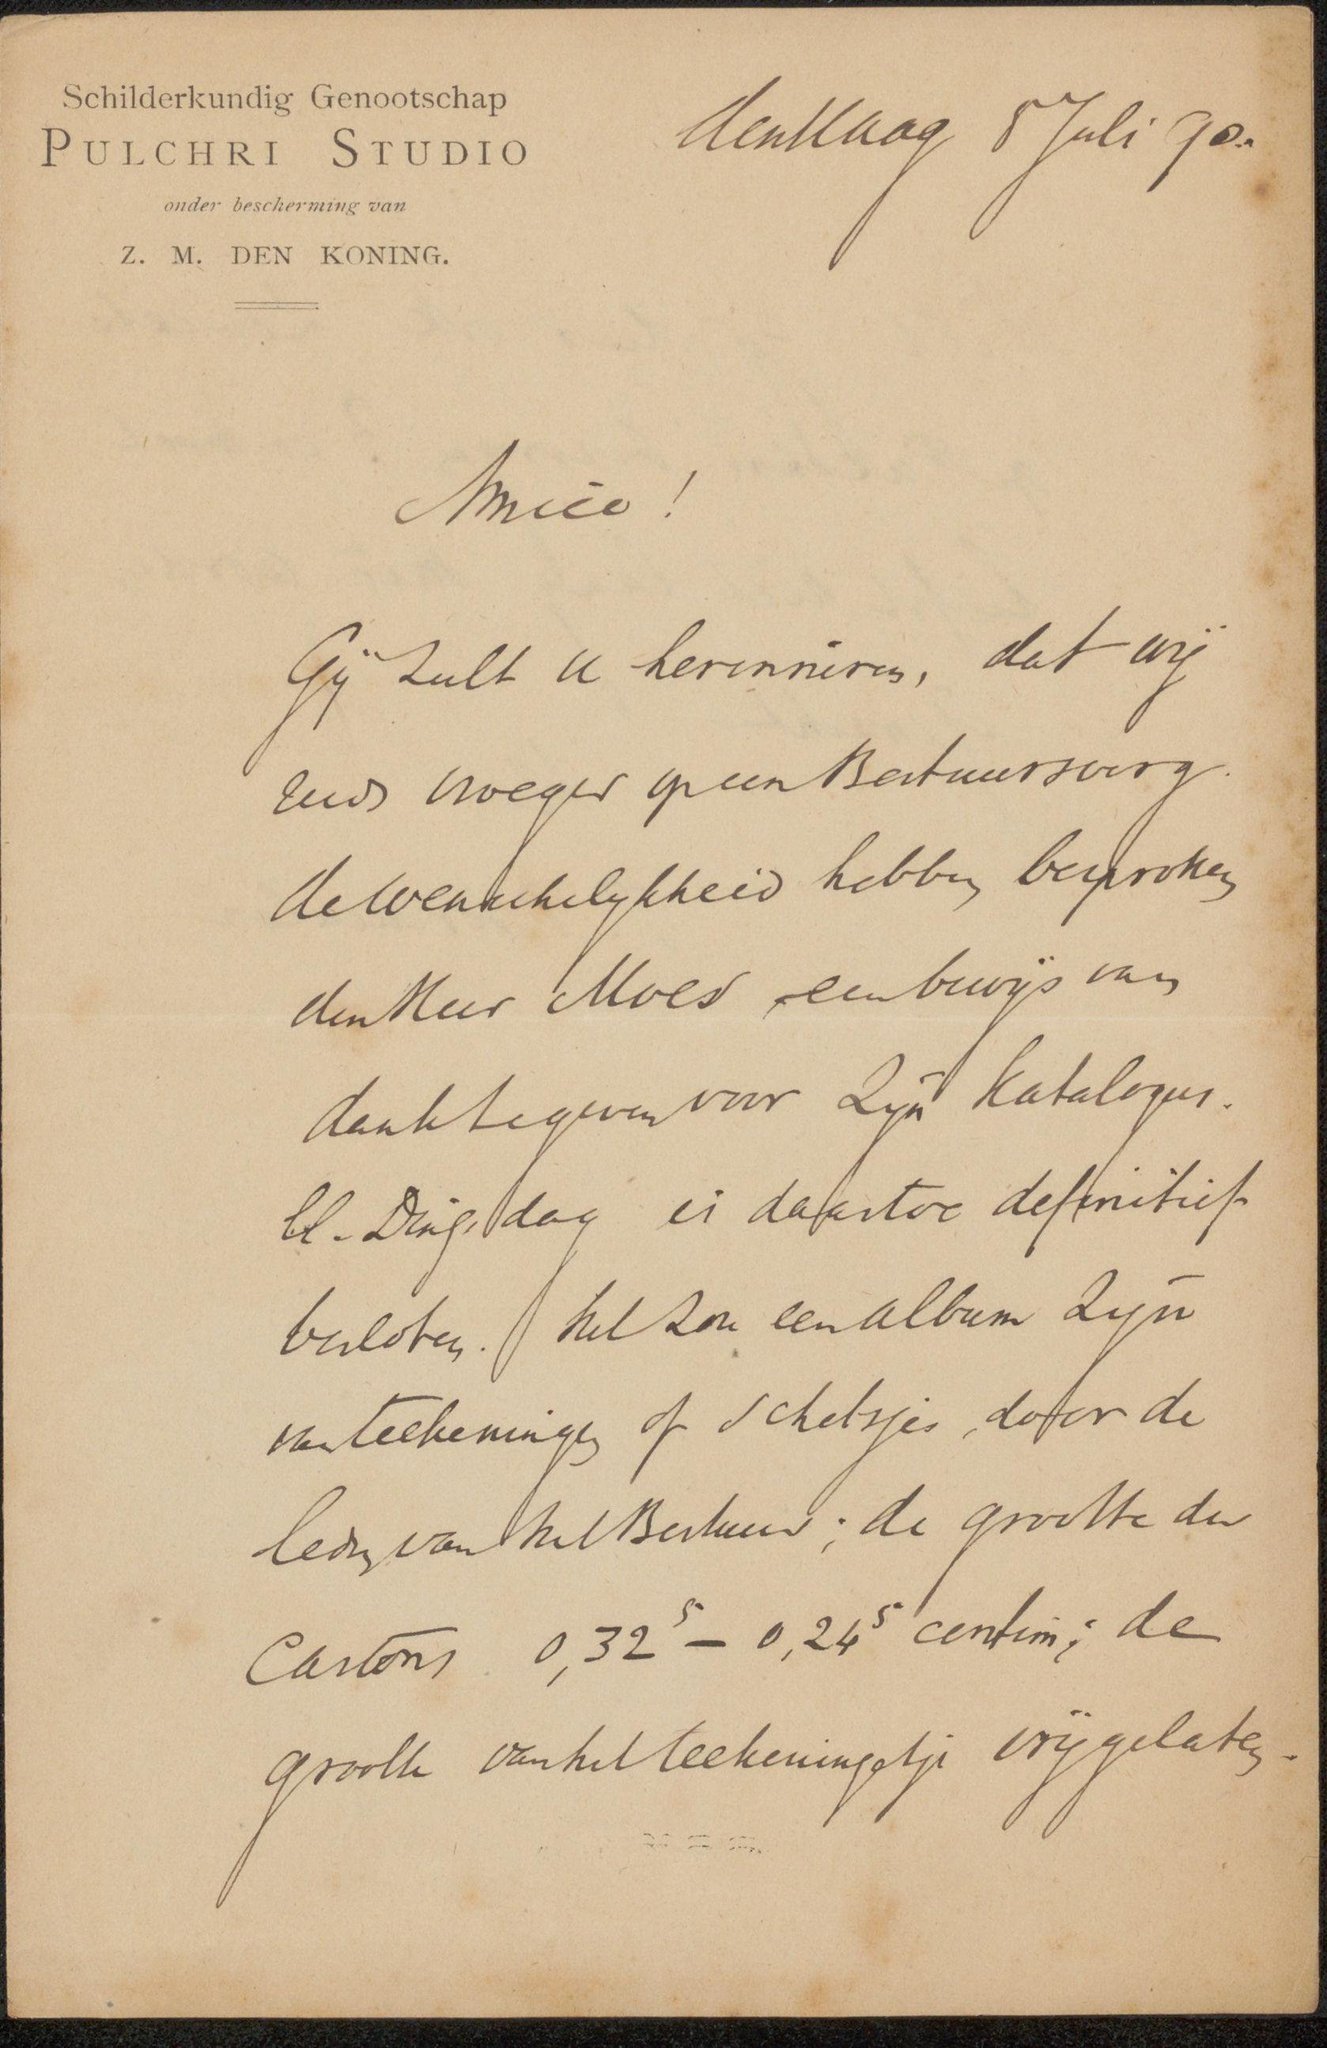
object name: letter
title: Brief aan Philip Zilcken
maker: françois pieter ter meulen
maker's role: painter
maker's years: 1843-1927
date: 1890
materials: ink, paper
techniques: pen, printing, writing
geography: the hague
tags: draughtsman, philip zilcken, drawing, printed matter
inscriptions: collector's mark: ‘RPK’